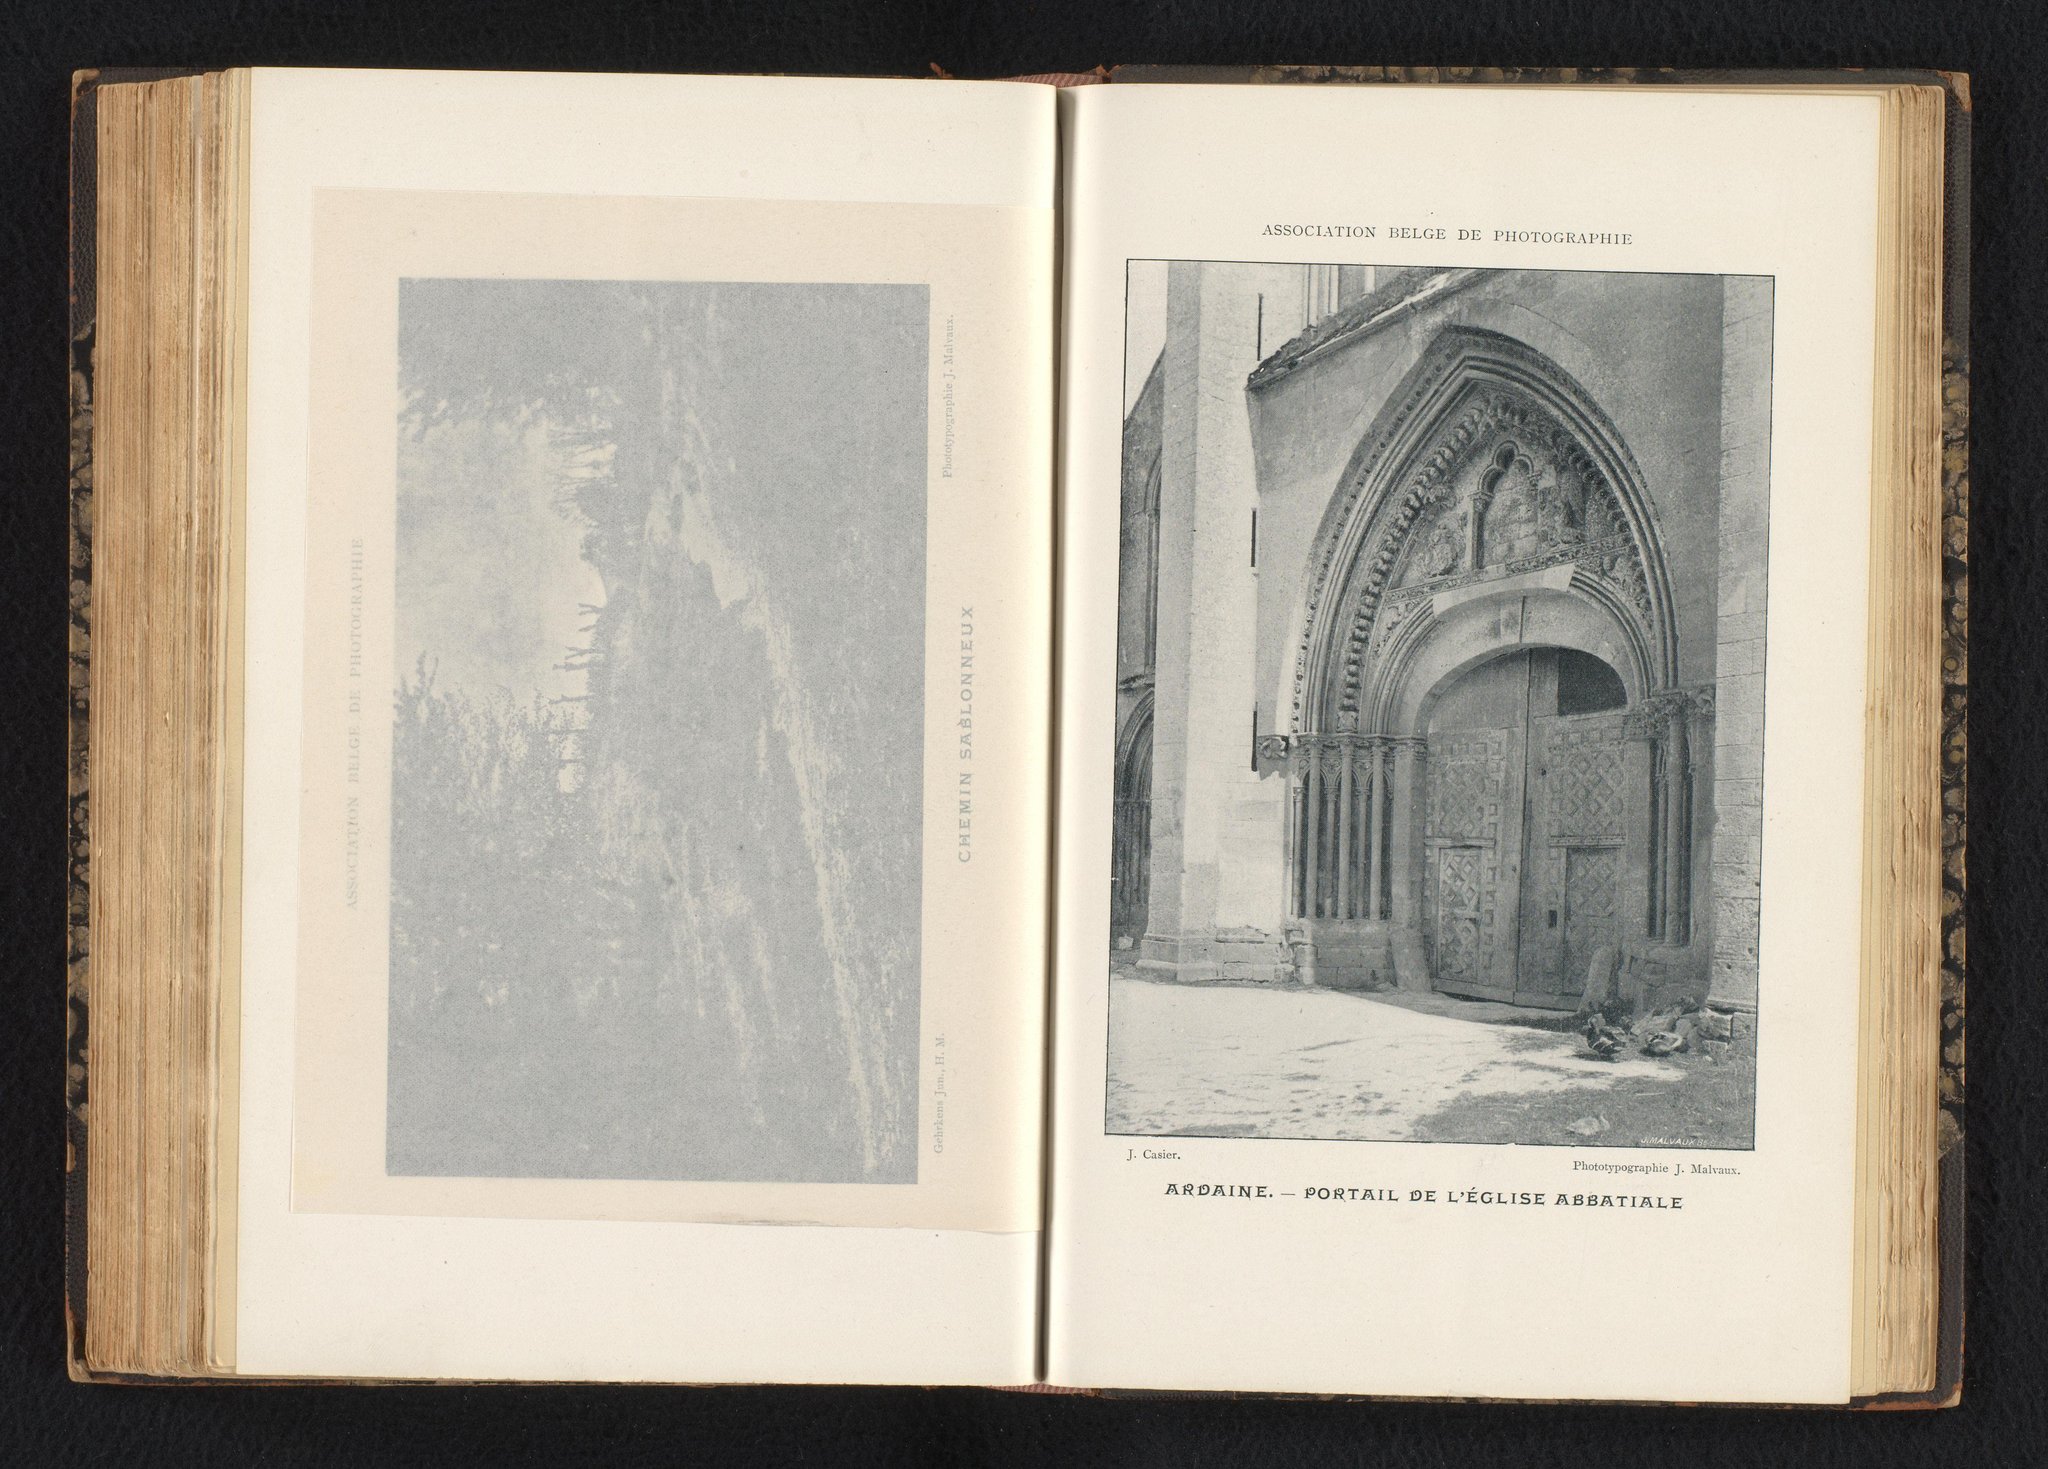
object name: page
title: Ardaine - Portail de l'église abbatiale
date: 1893-1898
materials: paper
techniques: autotype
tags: door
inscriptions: inscription: ‘Association belge de photographie’